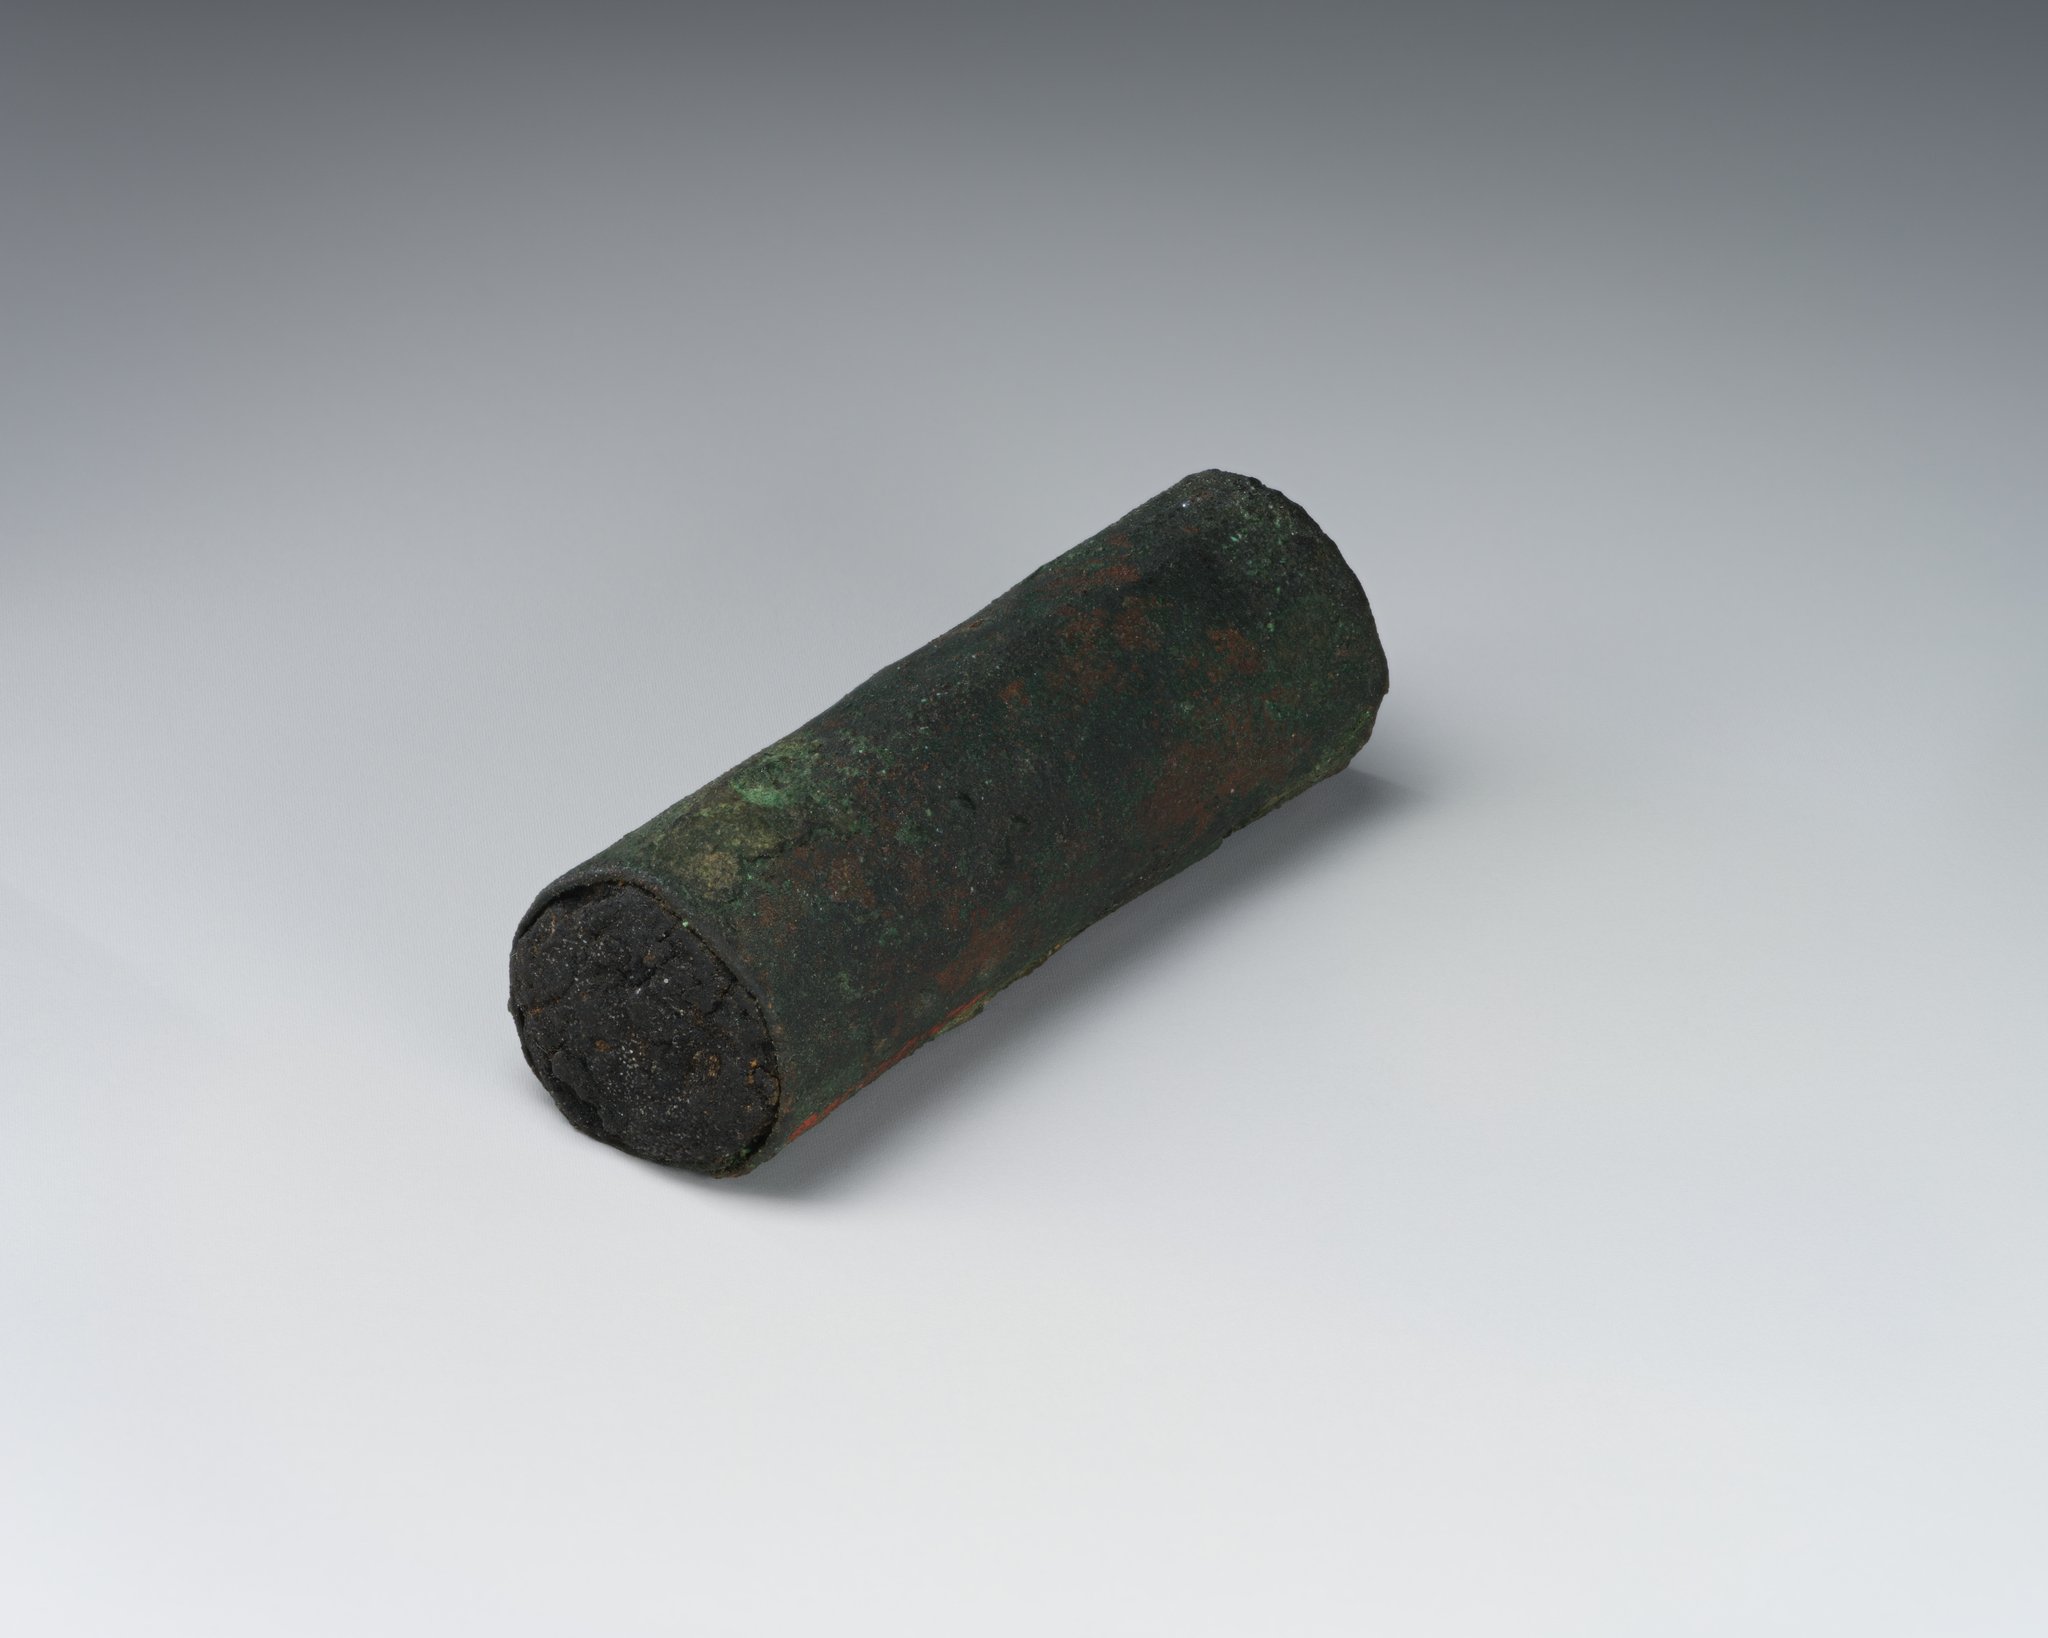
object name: amulet case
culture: sasanian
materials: copper, patina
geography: mesopotamia